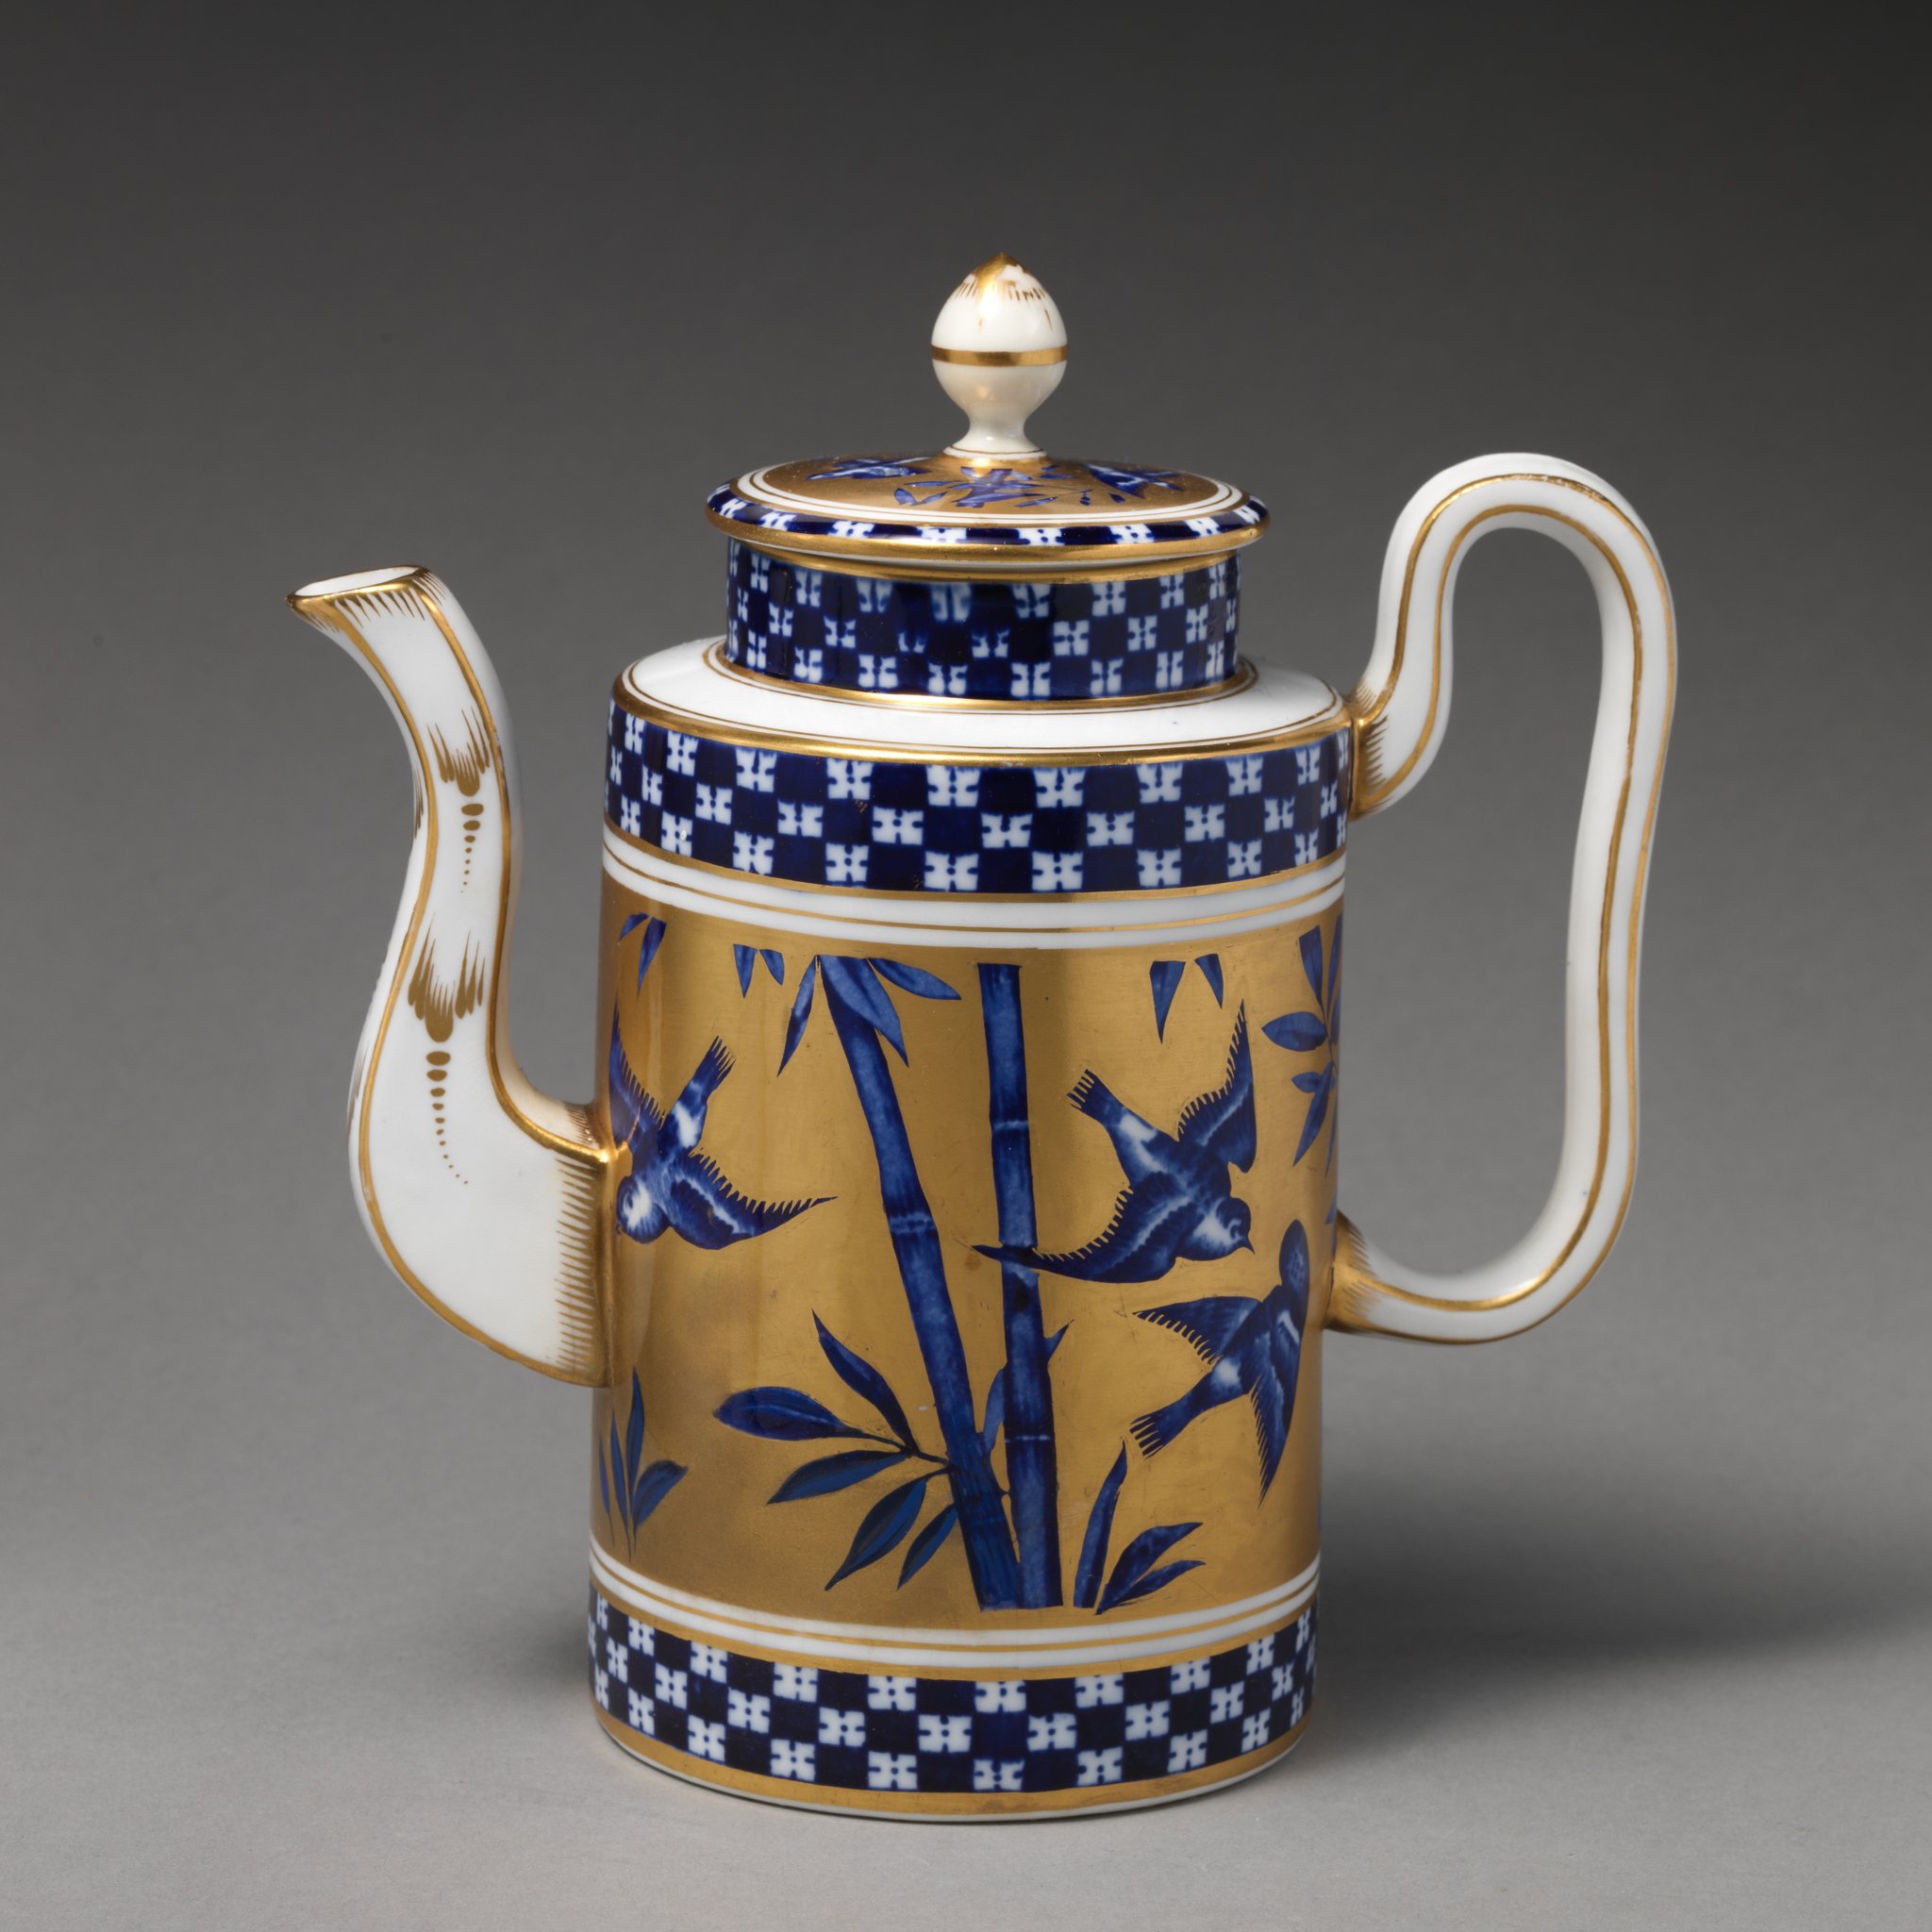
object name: coffeepot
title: Coffeepot (part of a service)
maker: coalport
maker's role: maker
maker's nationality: british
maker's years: 1794-1926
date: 1875-1881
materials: porcelain